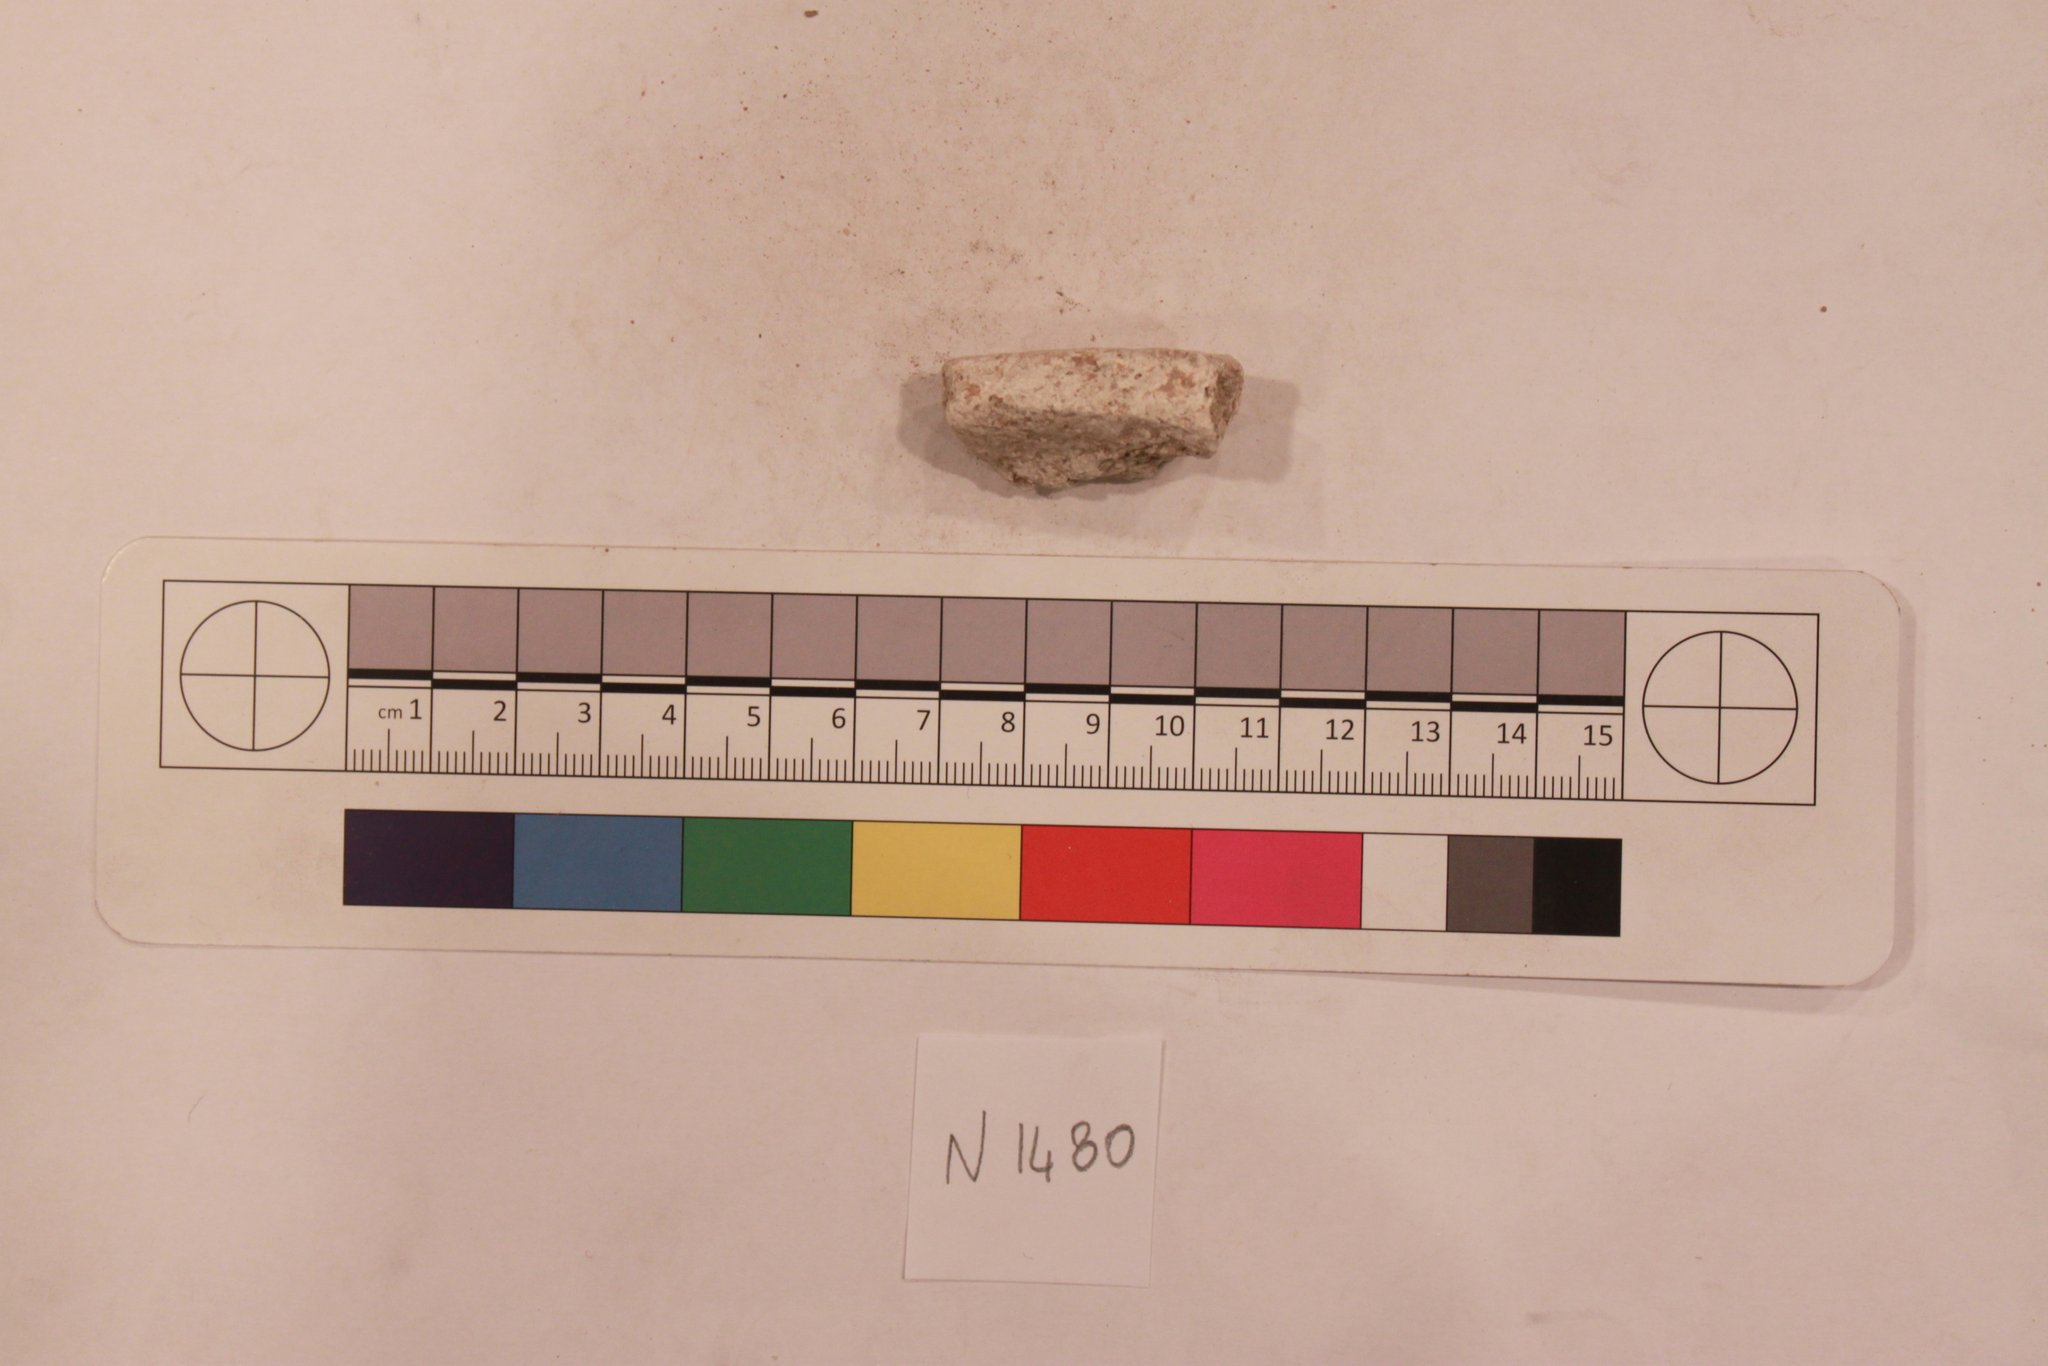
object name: fragment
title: Stucco Fragment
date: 701-1200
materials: plaster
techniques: carving, painting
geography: iran